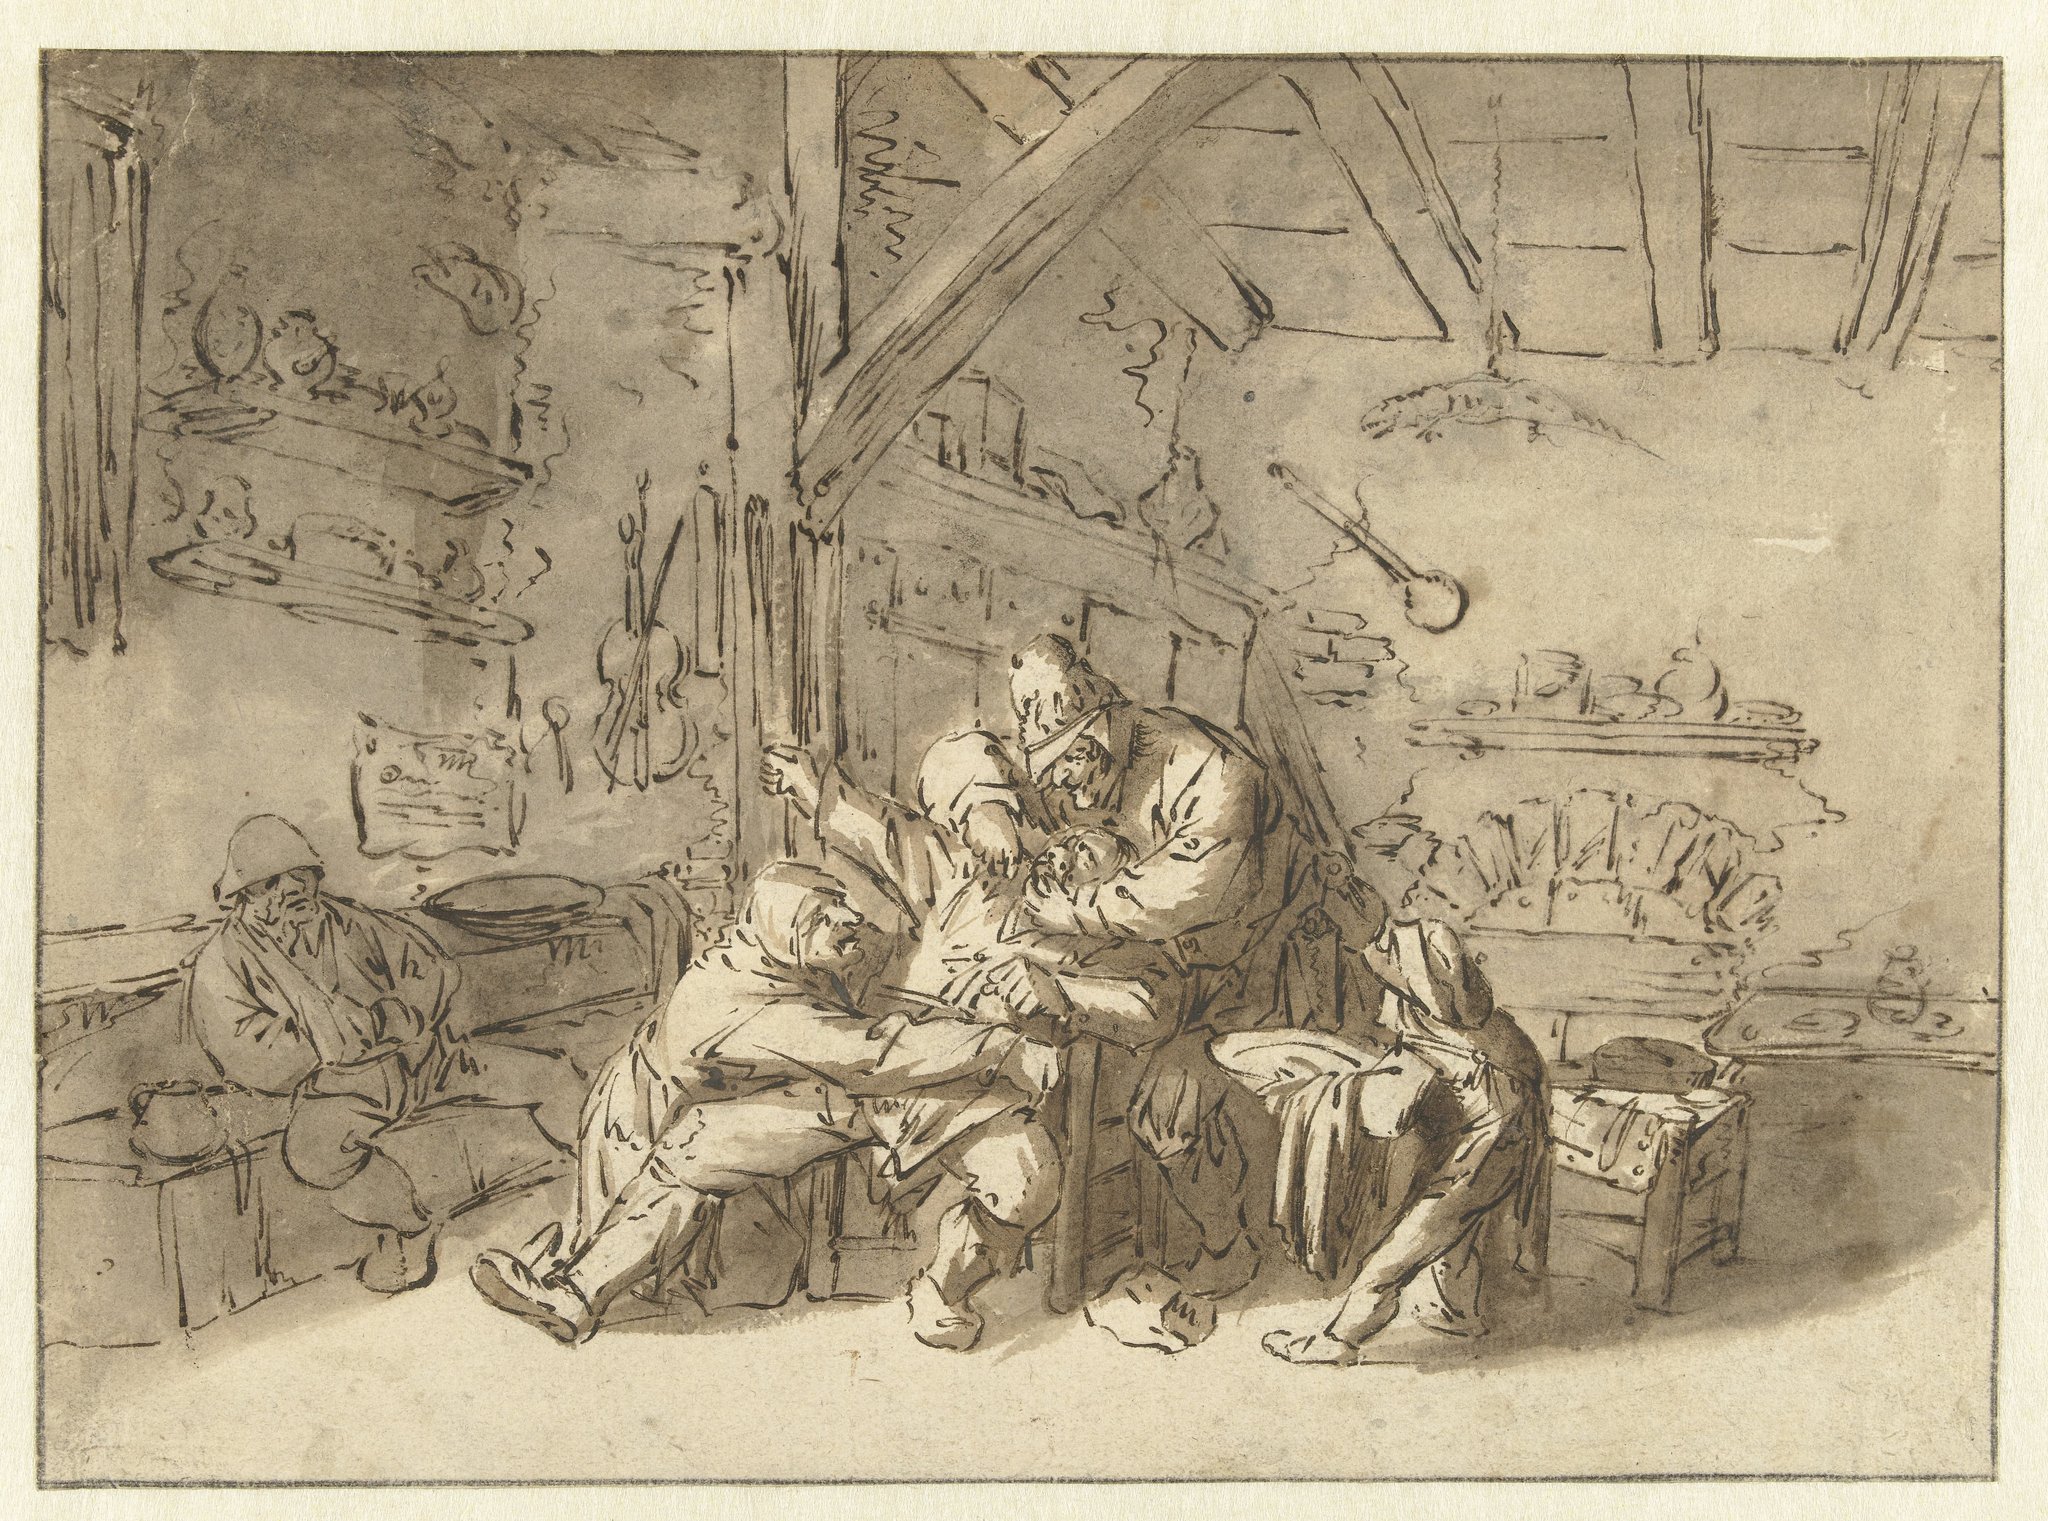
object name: drawing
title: De kiezentrekker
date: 1675-1699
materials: ink, paper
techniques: brush, pen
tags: quack extracting teeth or molars